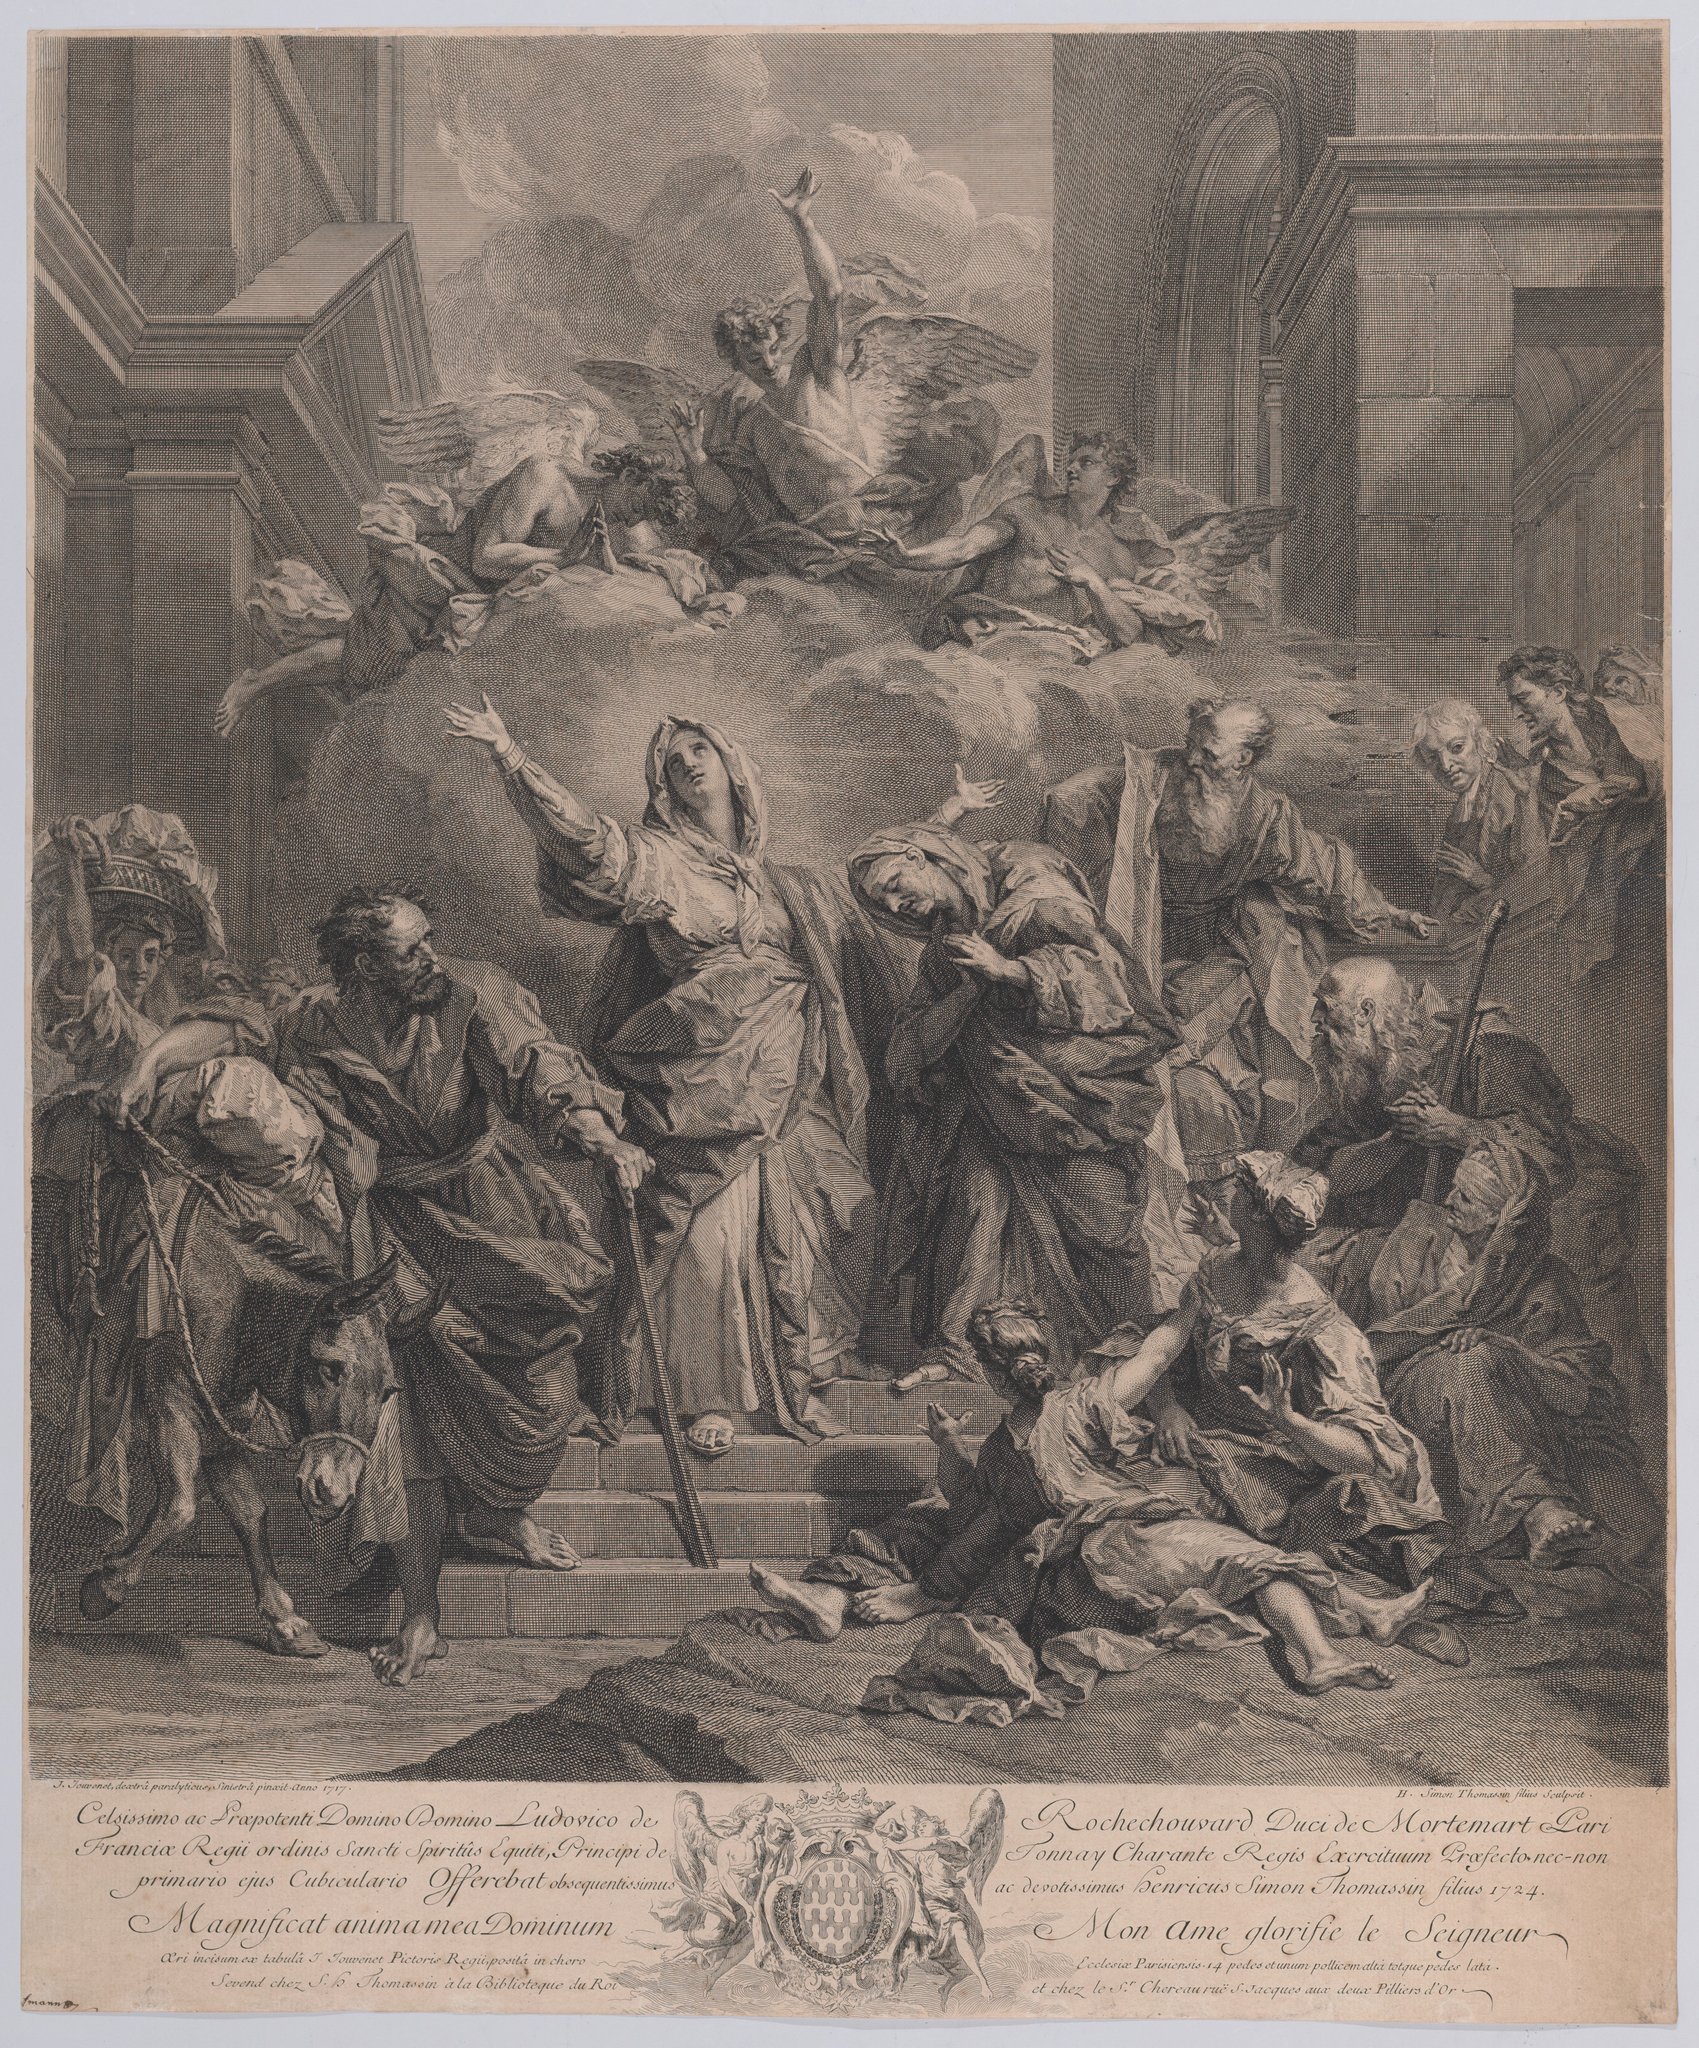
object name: print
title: The Magnificat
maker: henri simon thomassin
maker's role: artist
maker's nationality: french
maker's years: 1687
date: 1724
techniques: etching